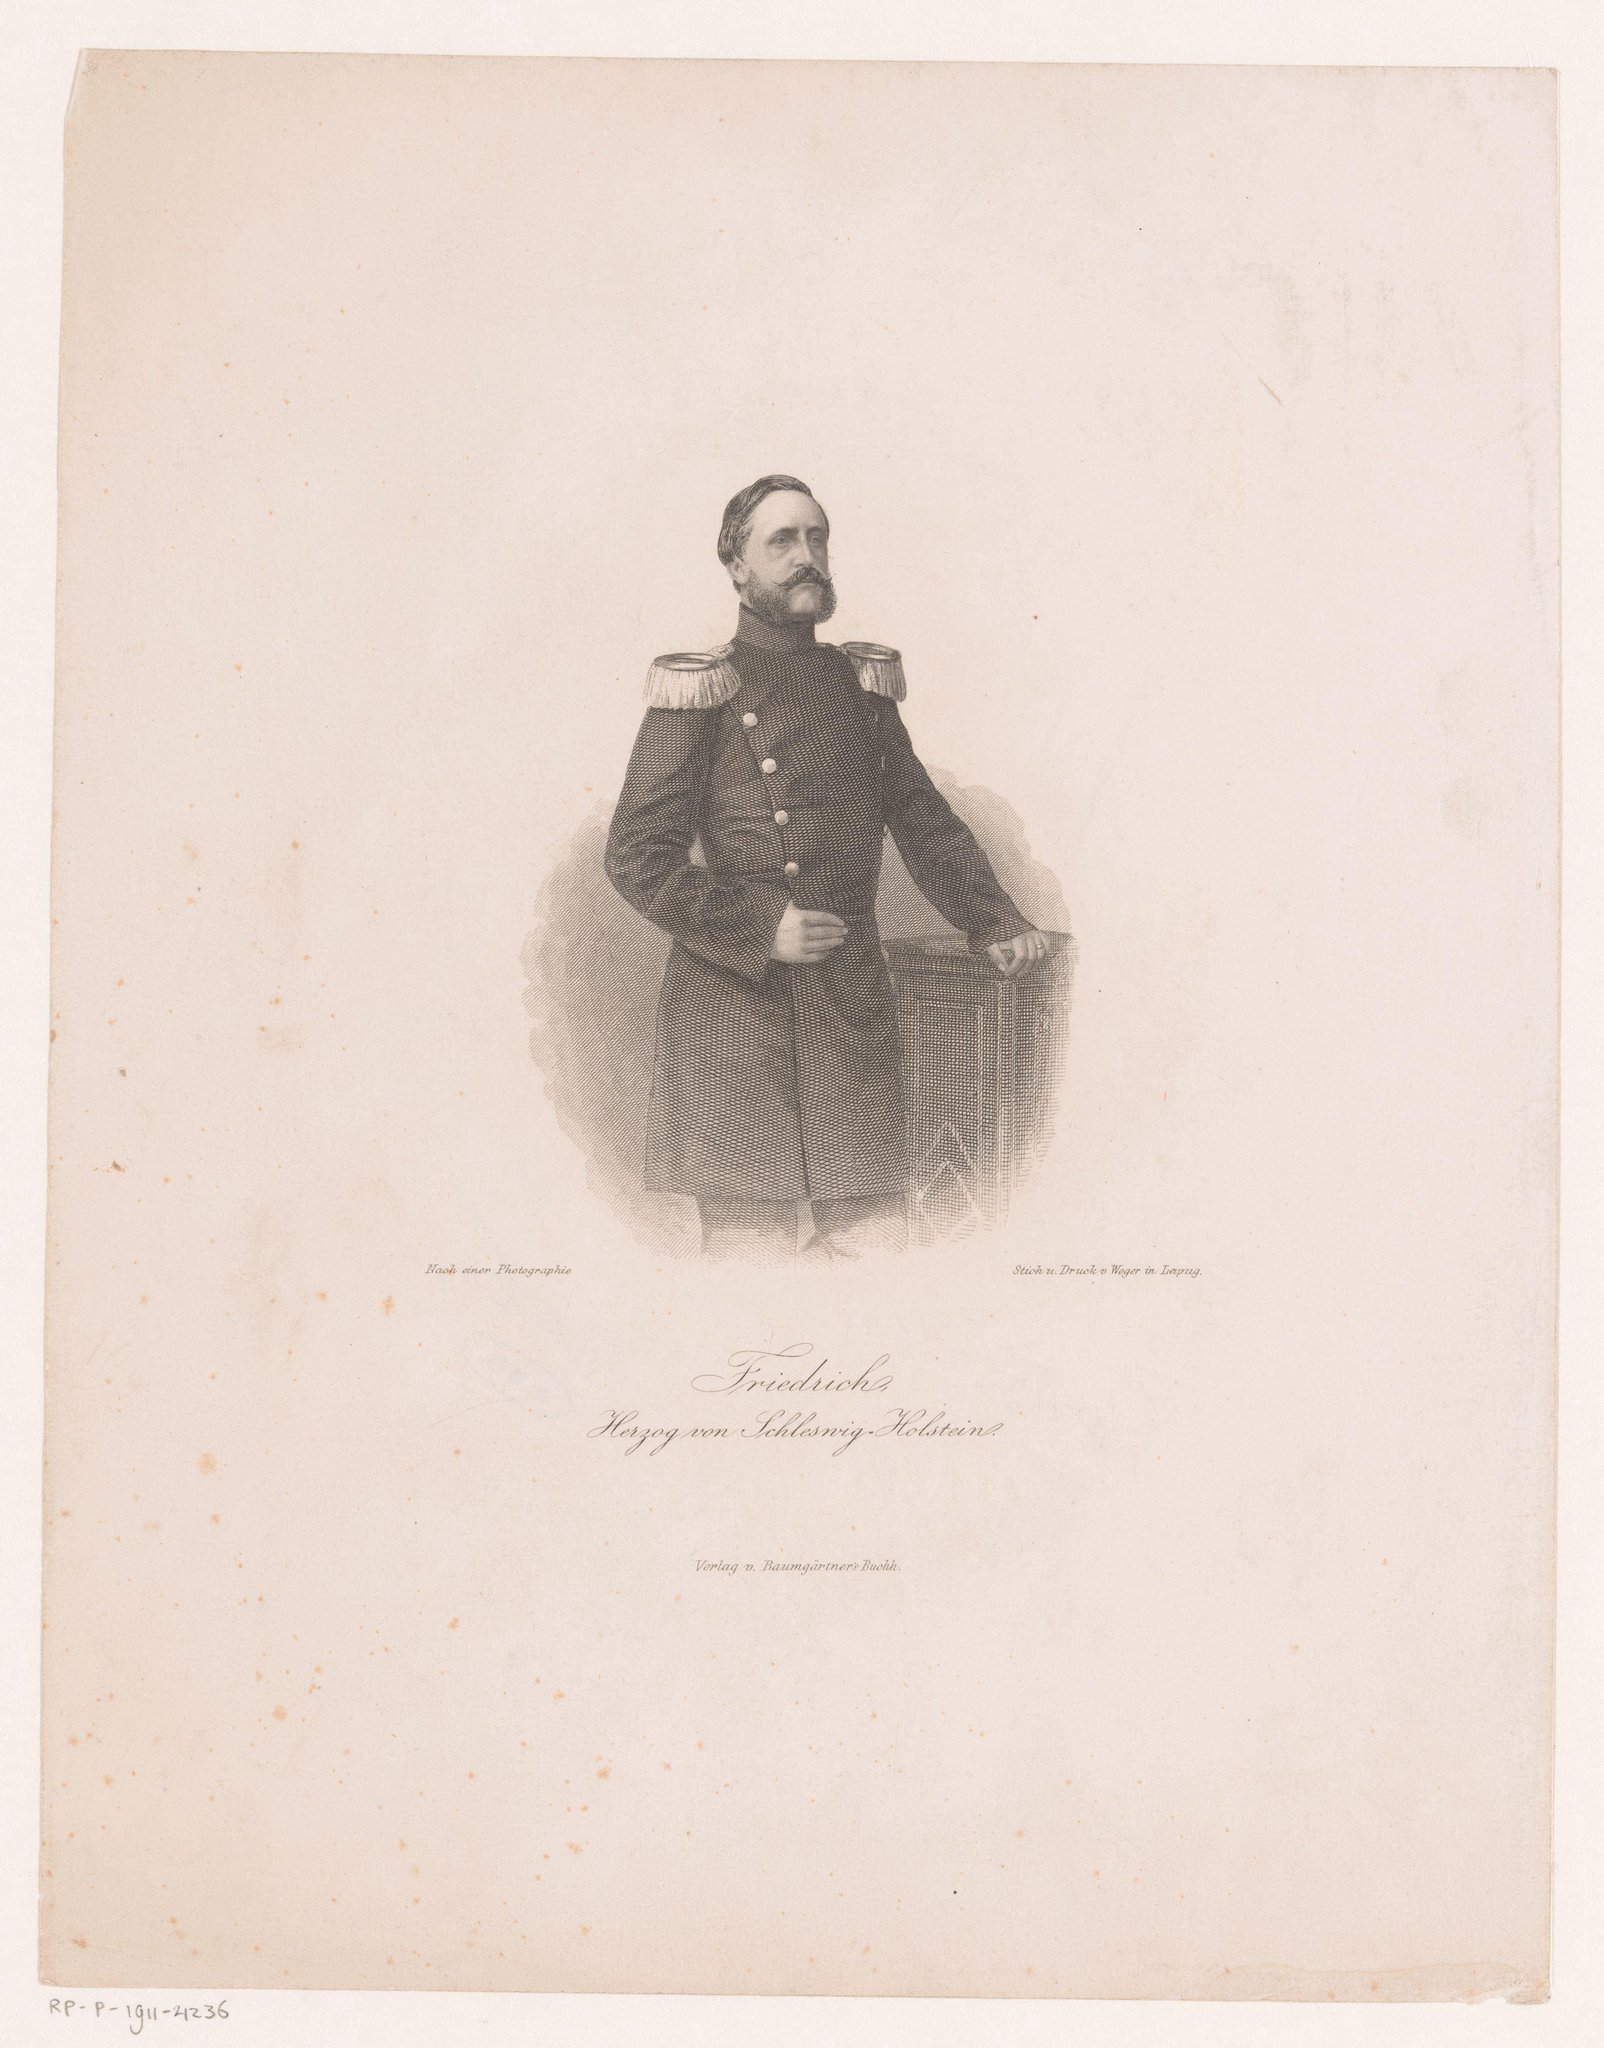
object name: print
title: Portret van Friedrich VIII, Herzog von Schleswig-Holstein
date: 1860-1892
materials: paper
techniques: engraving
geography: leipzig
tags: denmark, historical persons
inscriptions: collector's mark: Lugt 2228